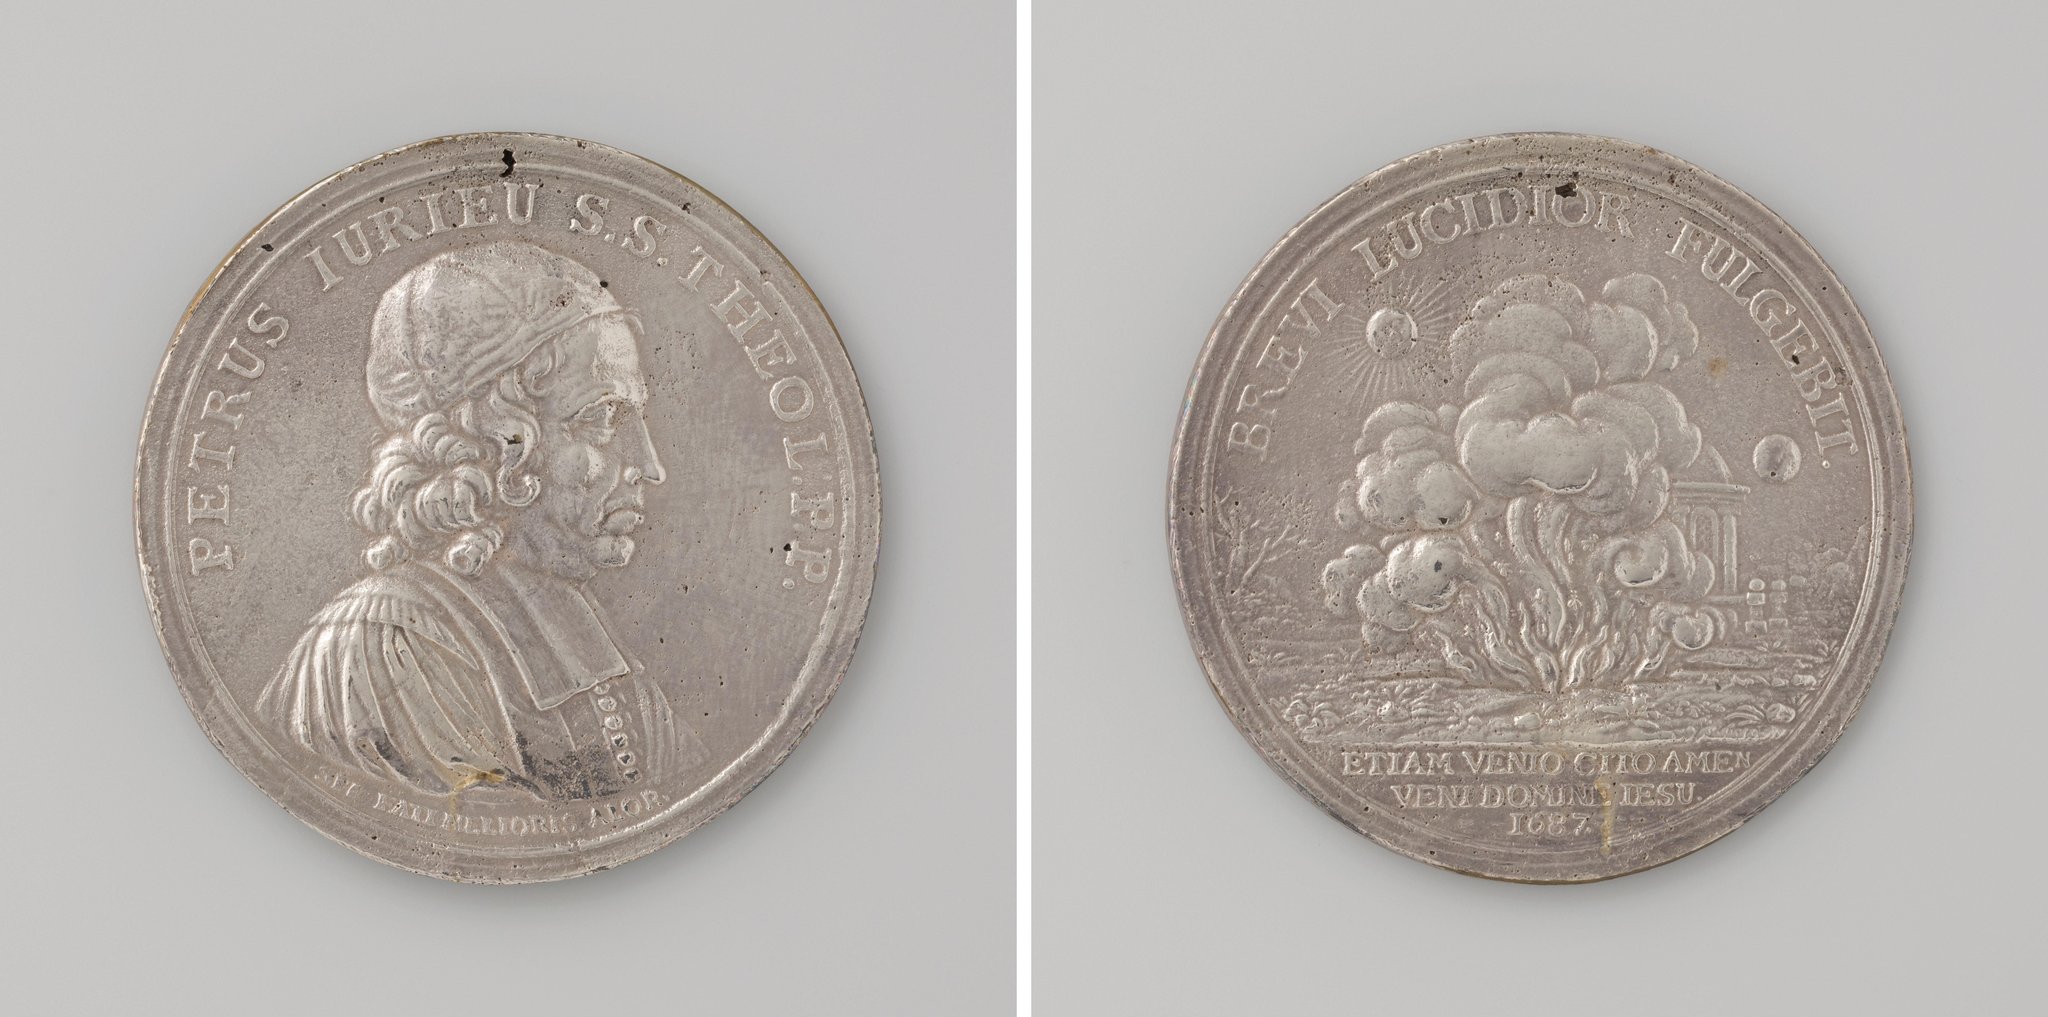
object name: history medal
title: Petrus Jurieu, hoogleraar en predikant van de Waalse gemeente te Rotterdam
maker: Anonymous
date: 1687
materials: silver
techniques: striking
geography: netherlands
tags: rotterdam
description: Zilveren penning. Voorzijde: borststuk man binnen omschrift. Keerzijde: sprinkhanen en rook afkomstig uit put van afgrond die kerk en zon verduisteren binnen omschrift; afsnede: opschrift